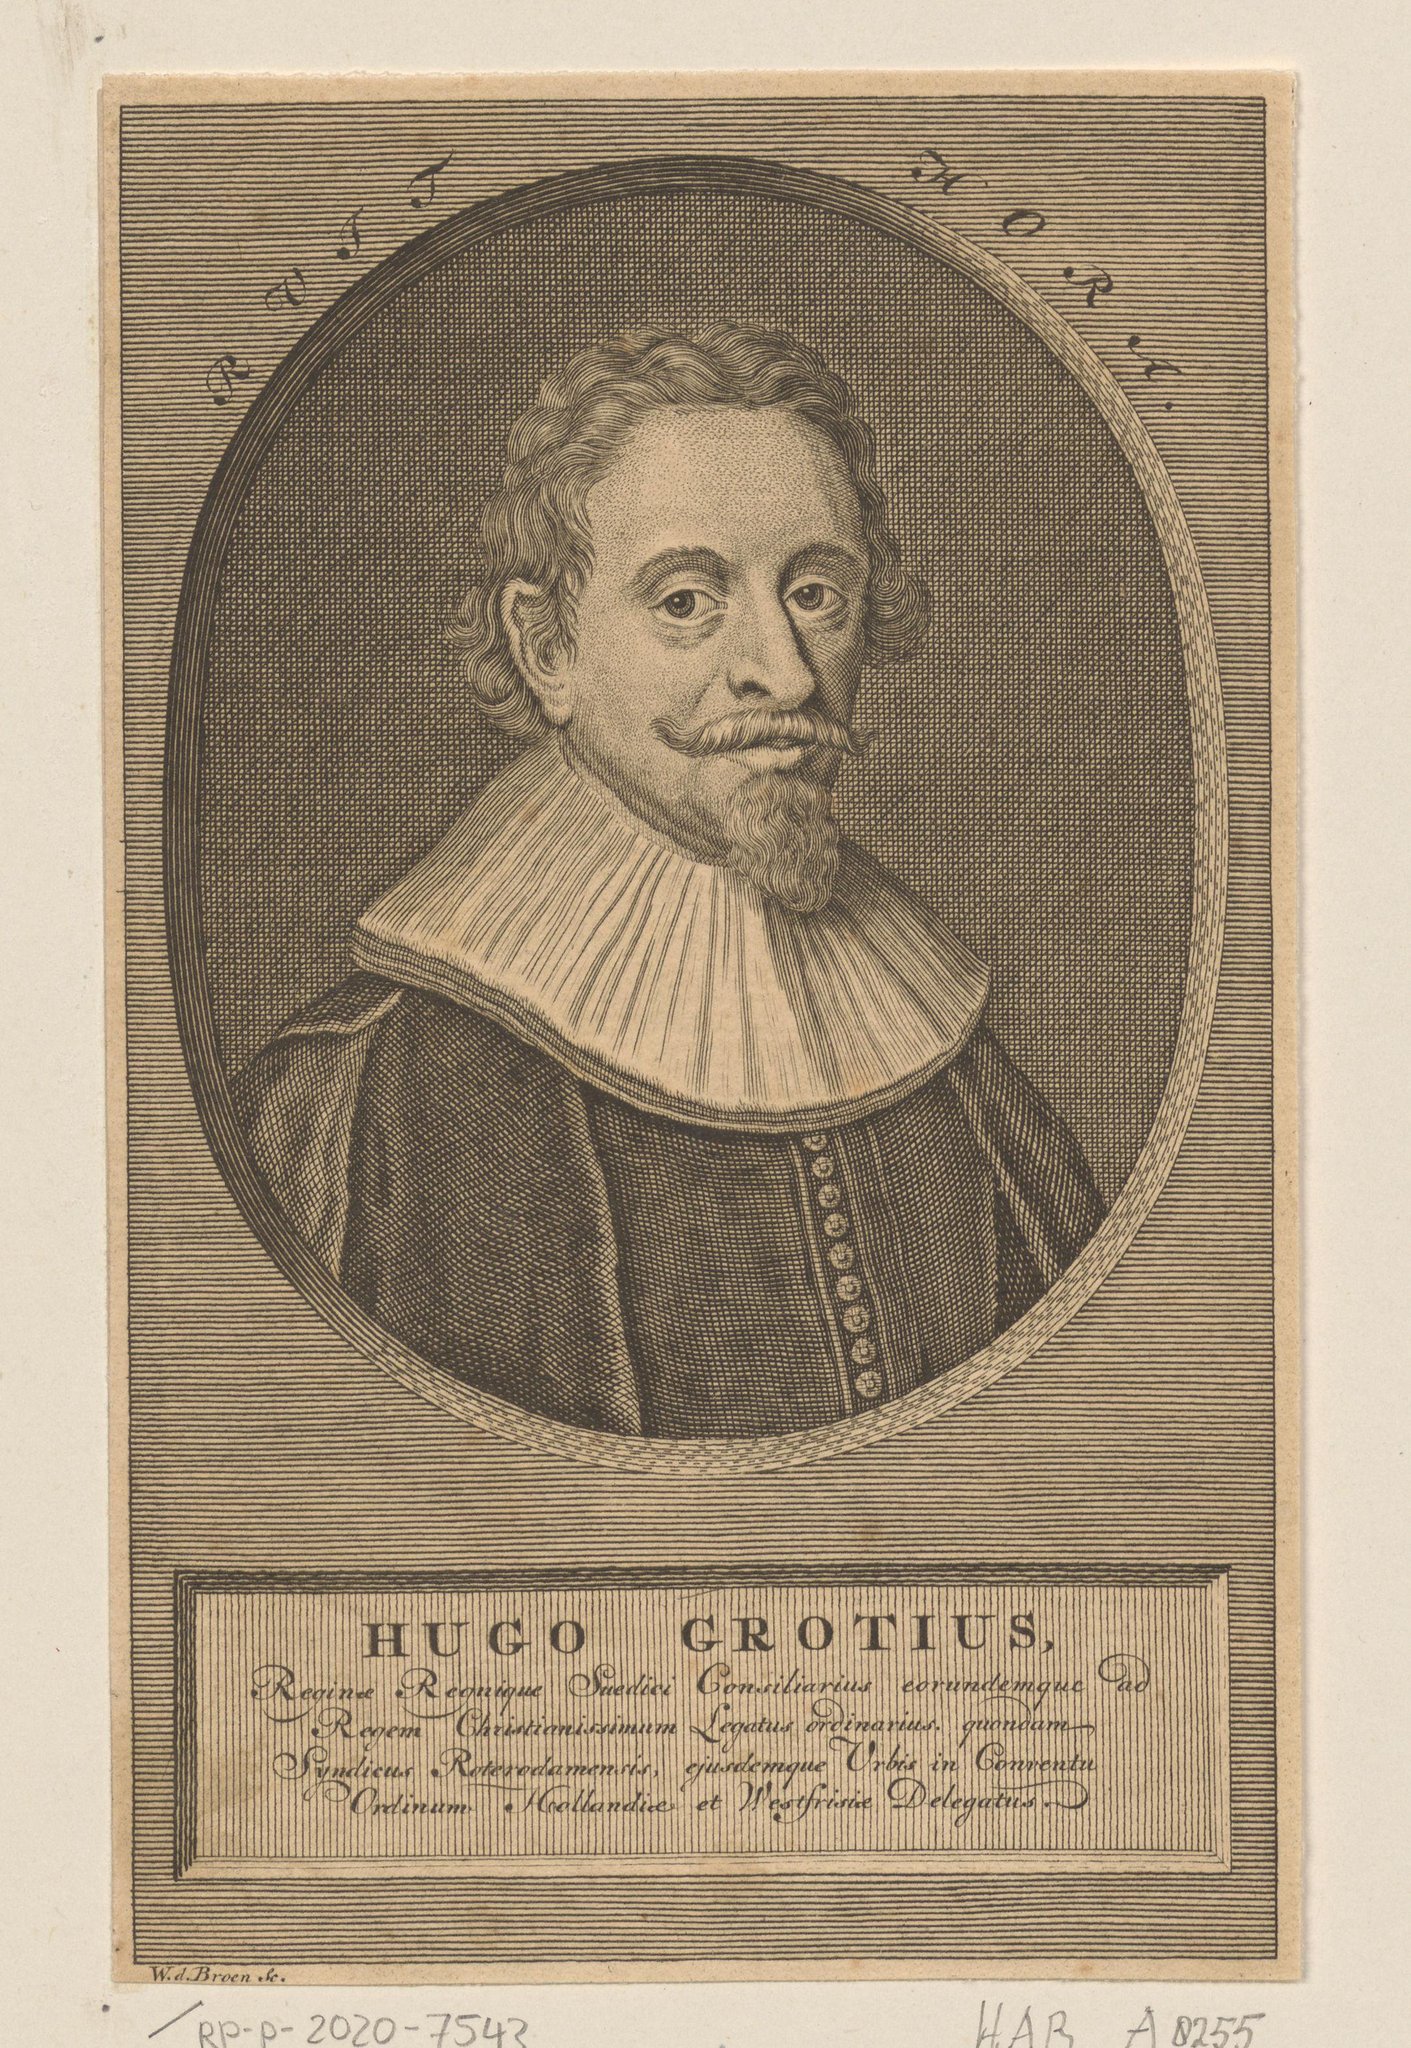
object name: print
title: Portret van Hugo de Groot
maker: willem de broen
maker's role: print maker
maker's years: 1686-1748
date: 1697-1748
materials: paper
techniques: engraving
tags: delft, hugo de groot, historical persons, portrait of a writer